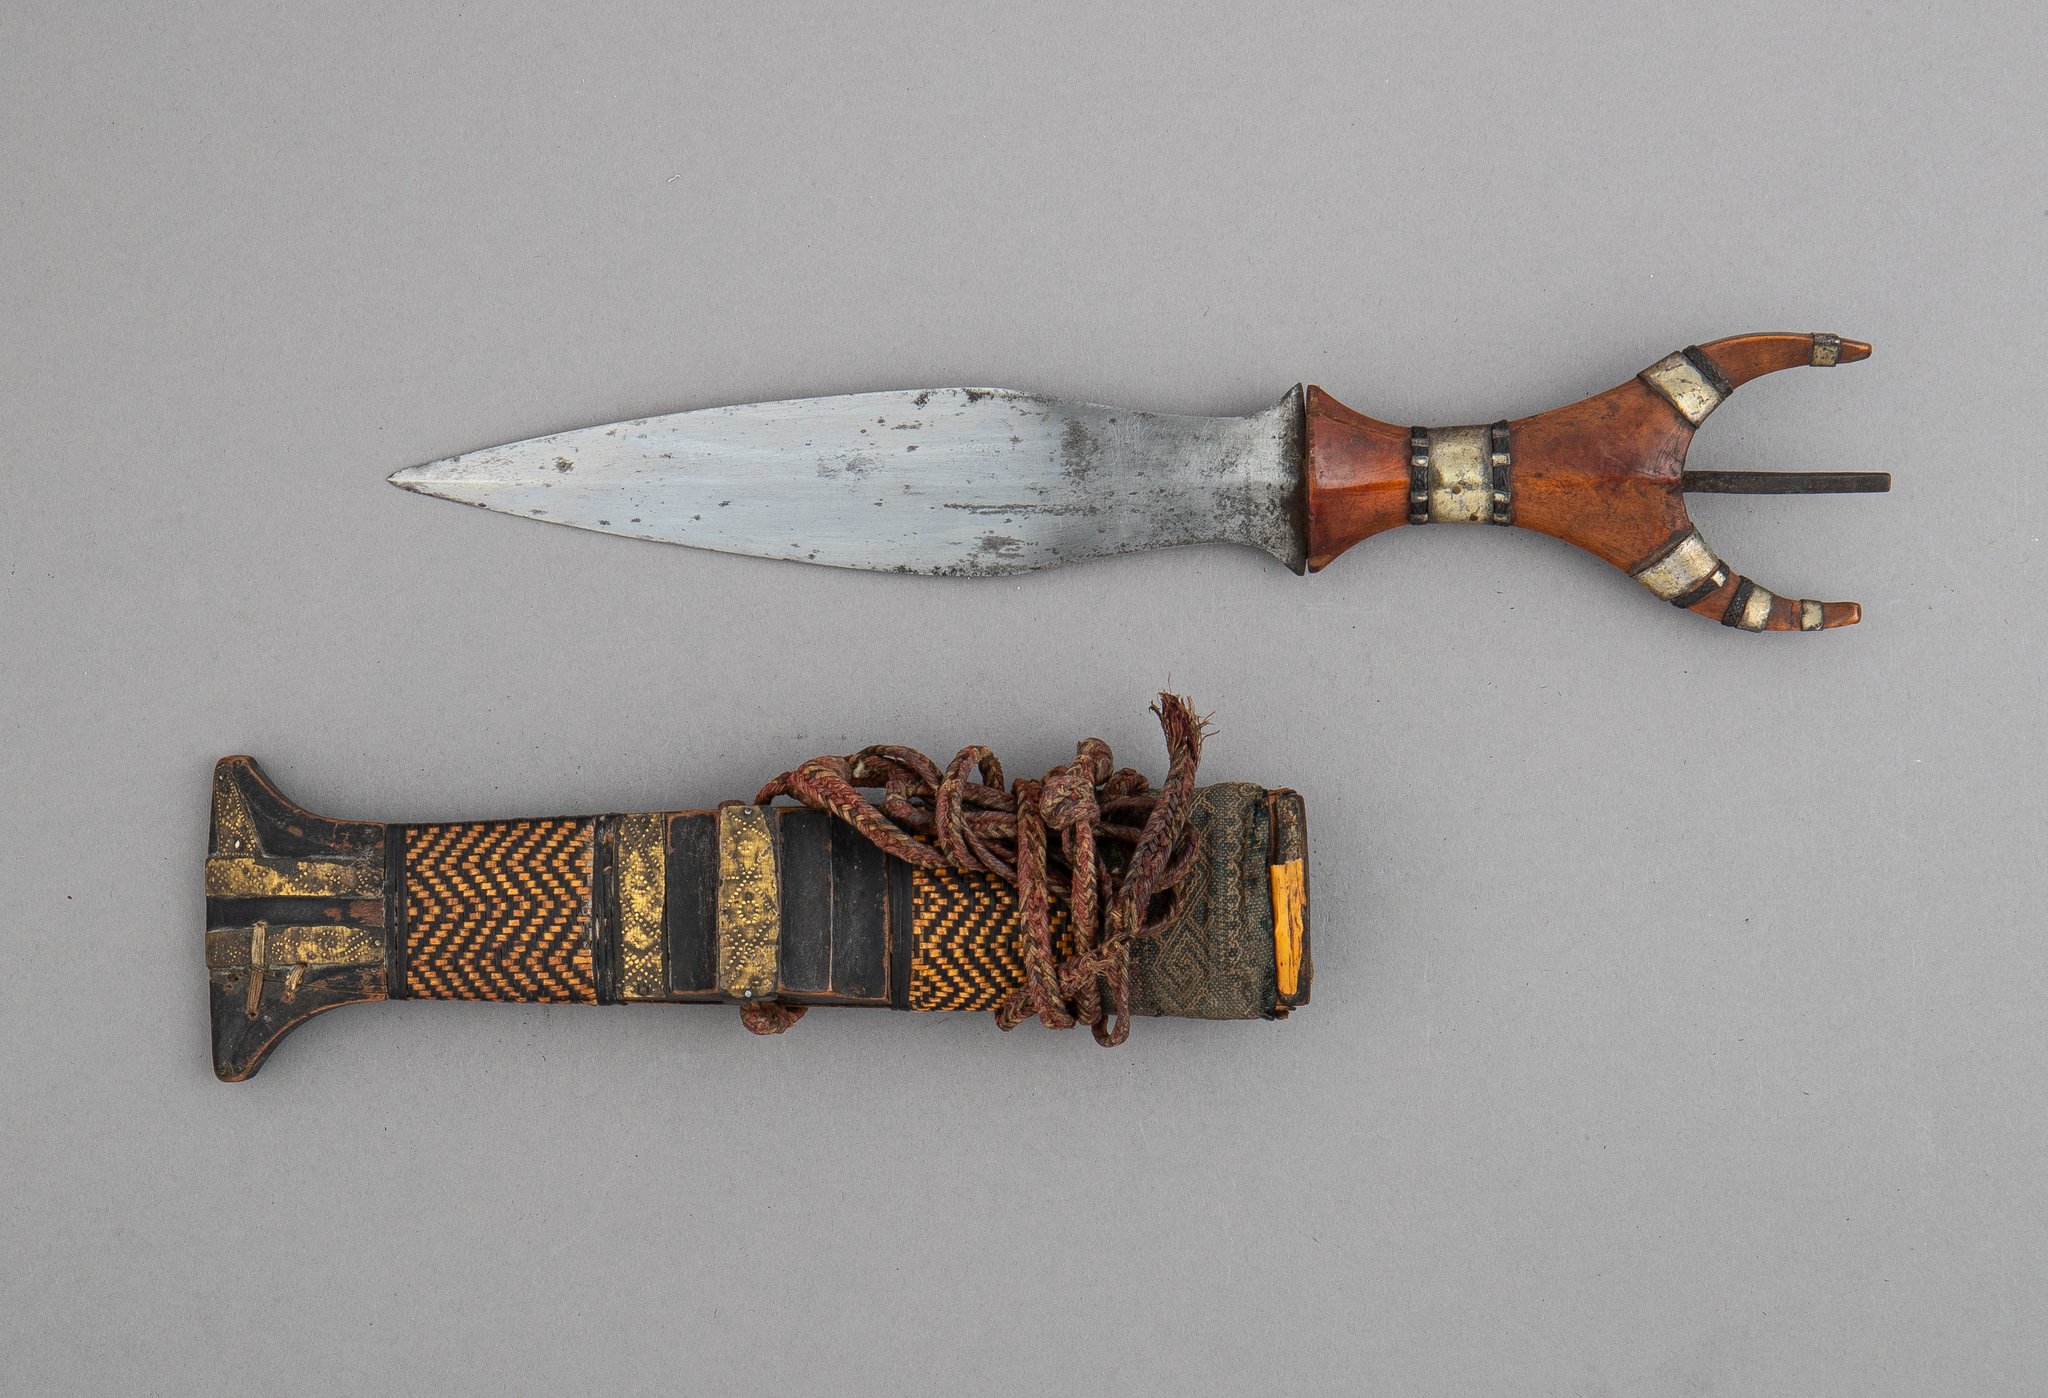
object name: dagger with sheath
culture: philippine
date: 1801-1900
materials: brass, leather, steel, textile, wood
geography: philippines